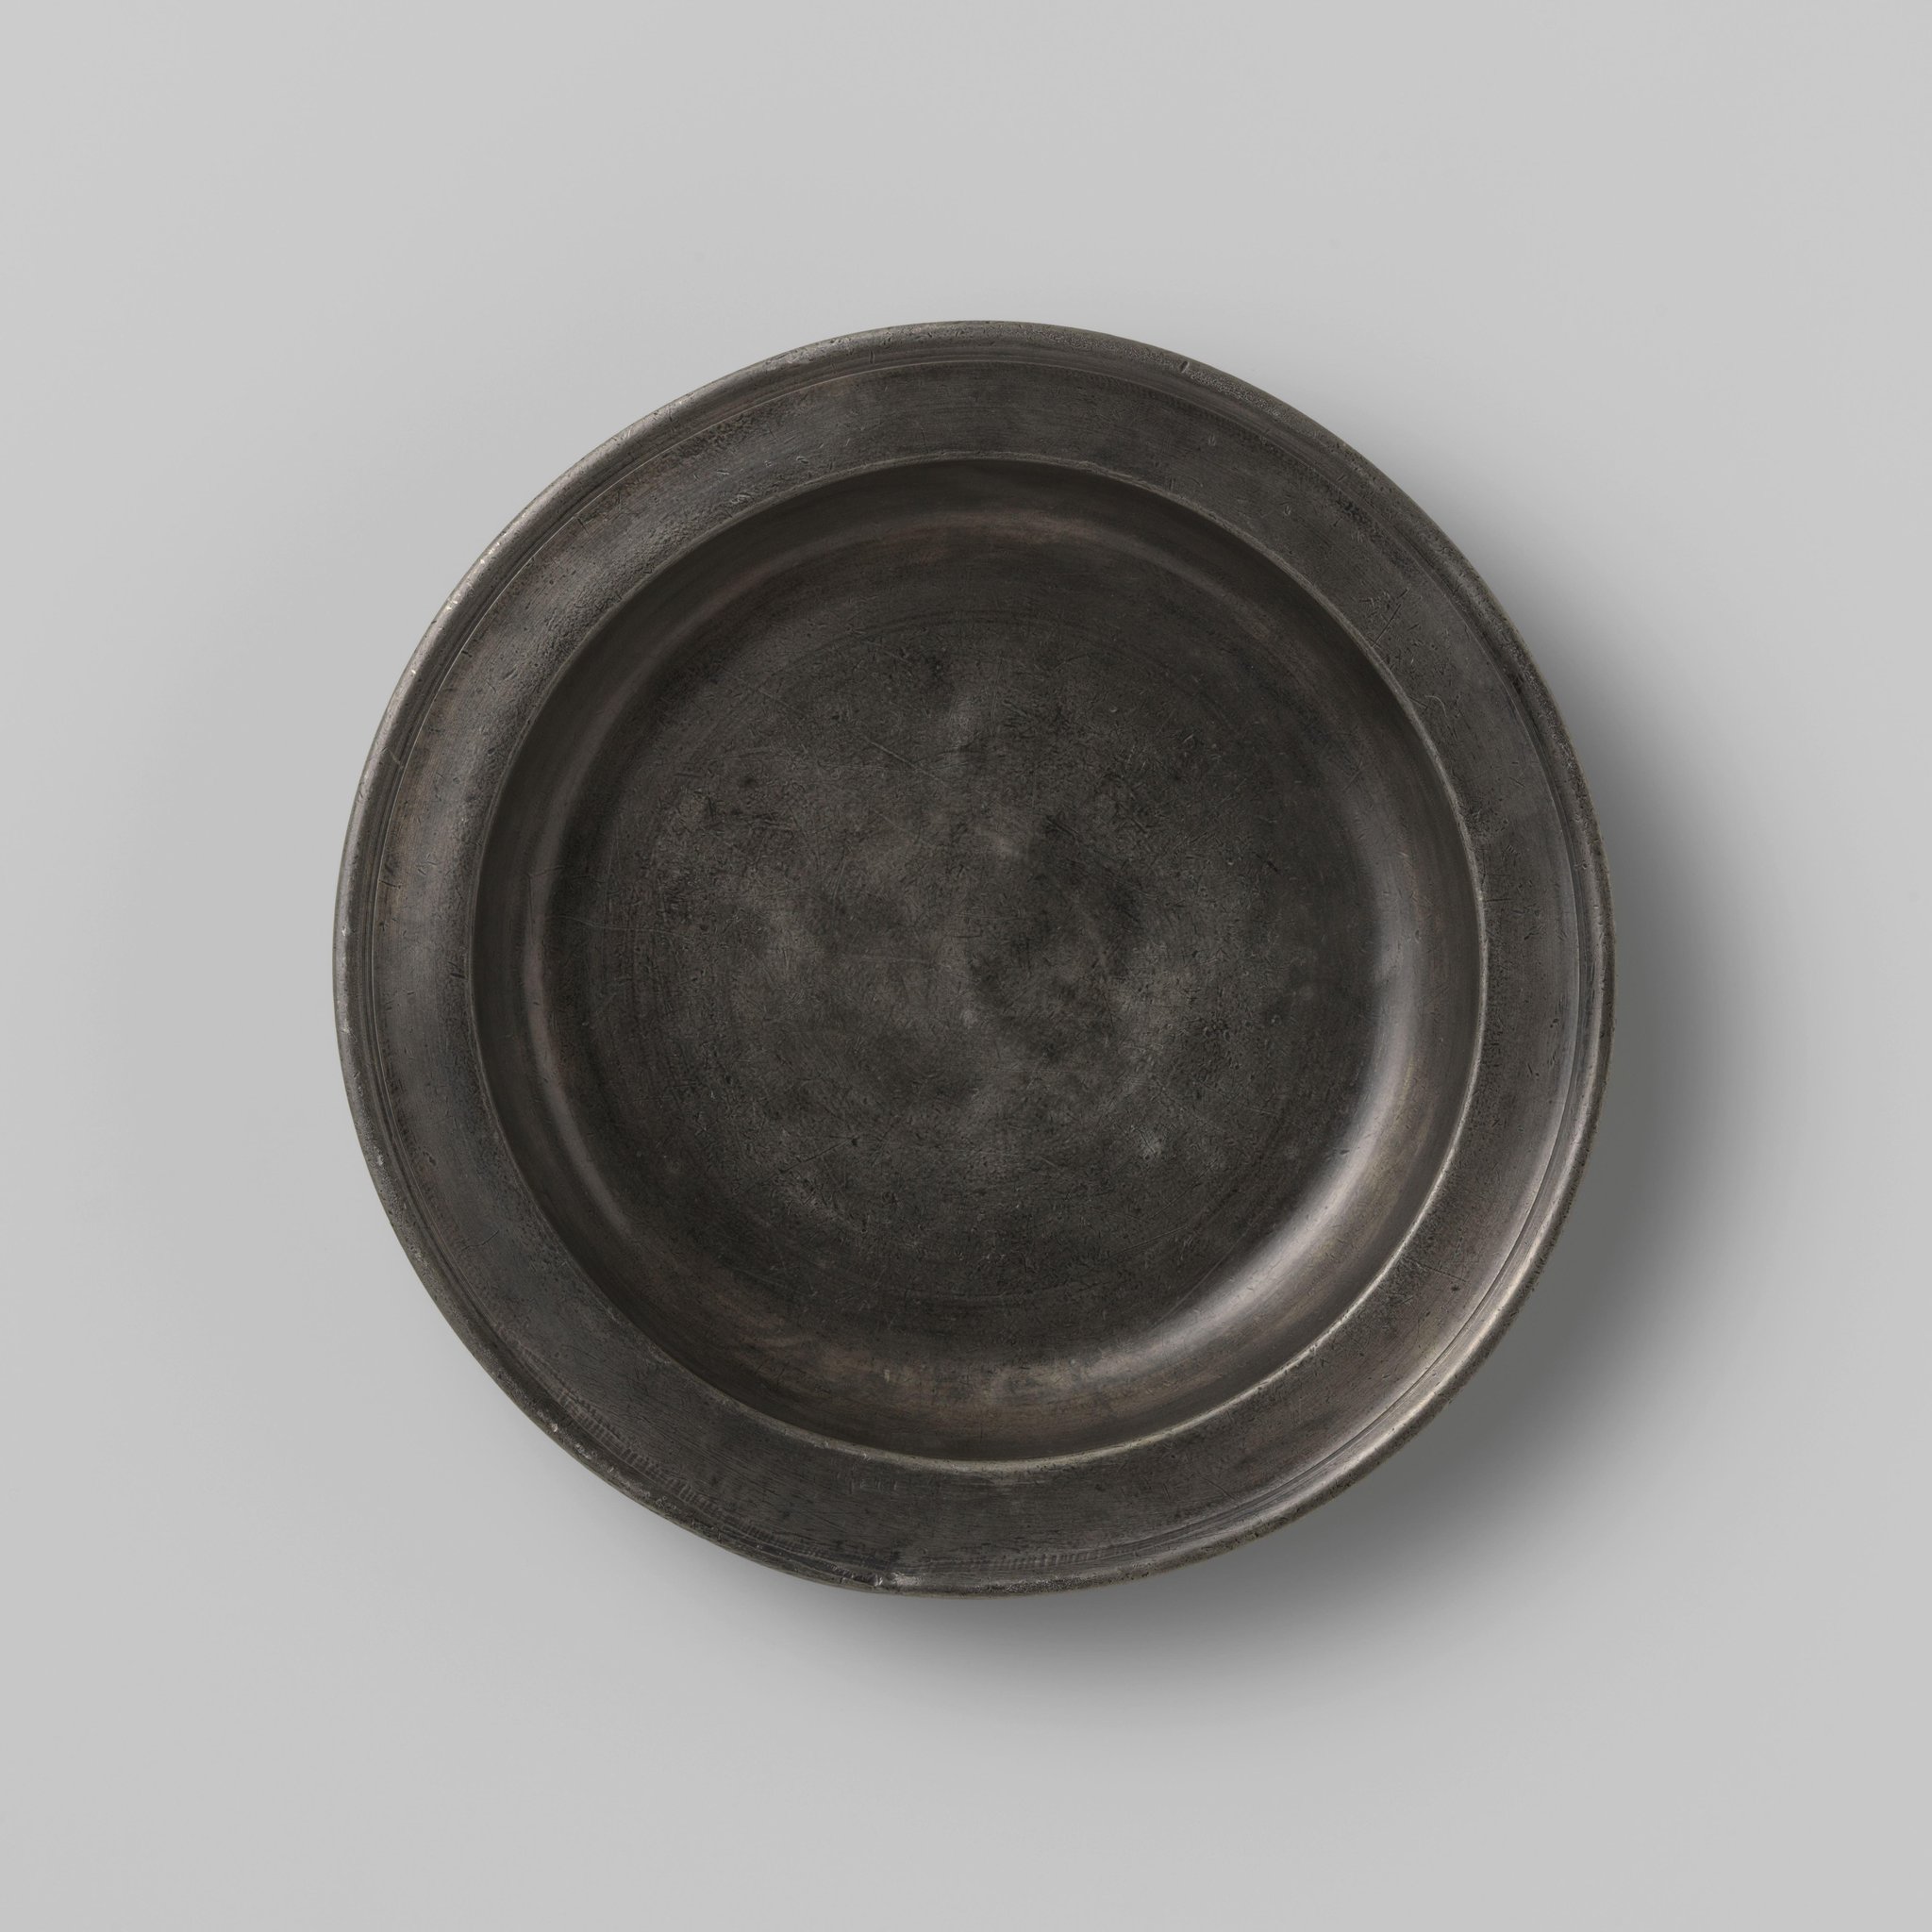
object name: plate dish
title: Bord van tin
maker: harm amsing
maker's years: 1849-1930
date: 1875-1900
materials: tin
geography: groningen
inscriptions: quality mark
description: Diep, rond bord van tin. De rand is geprofileerd.